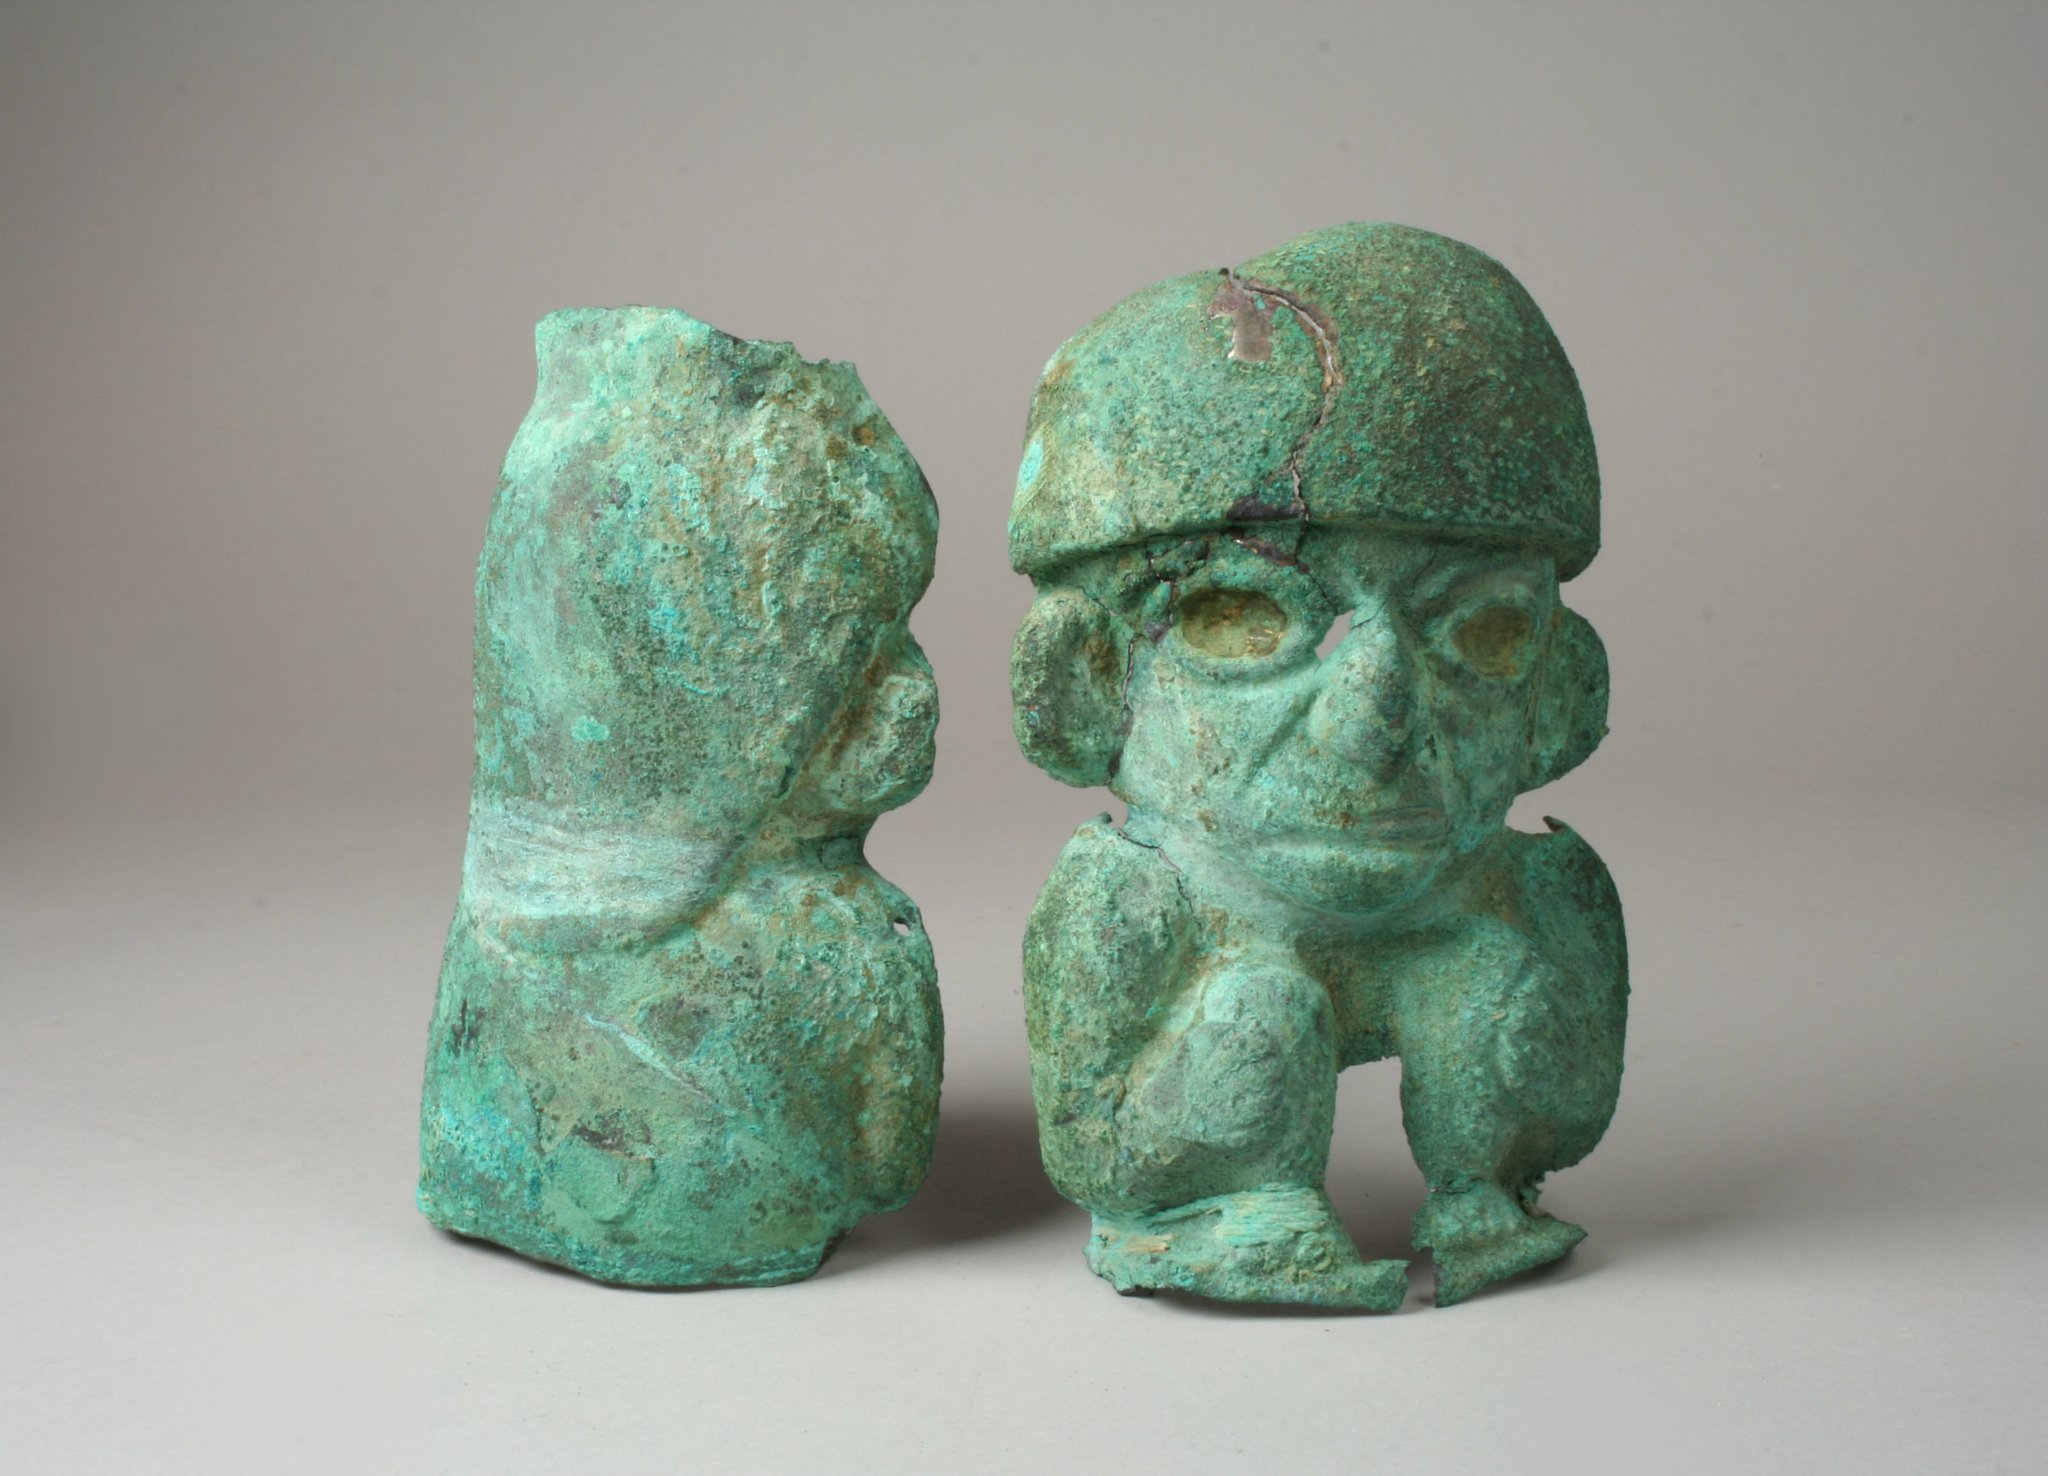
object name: ornament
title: Seated Figure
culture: moche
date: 501-700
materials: gilt copper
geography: peru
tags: men